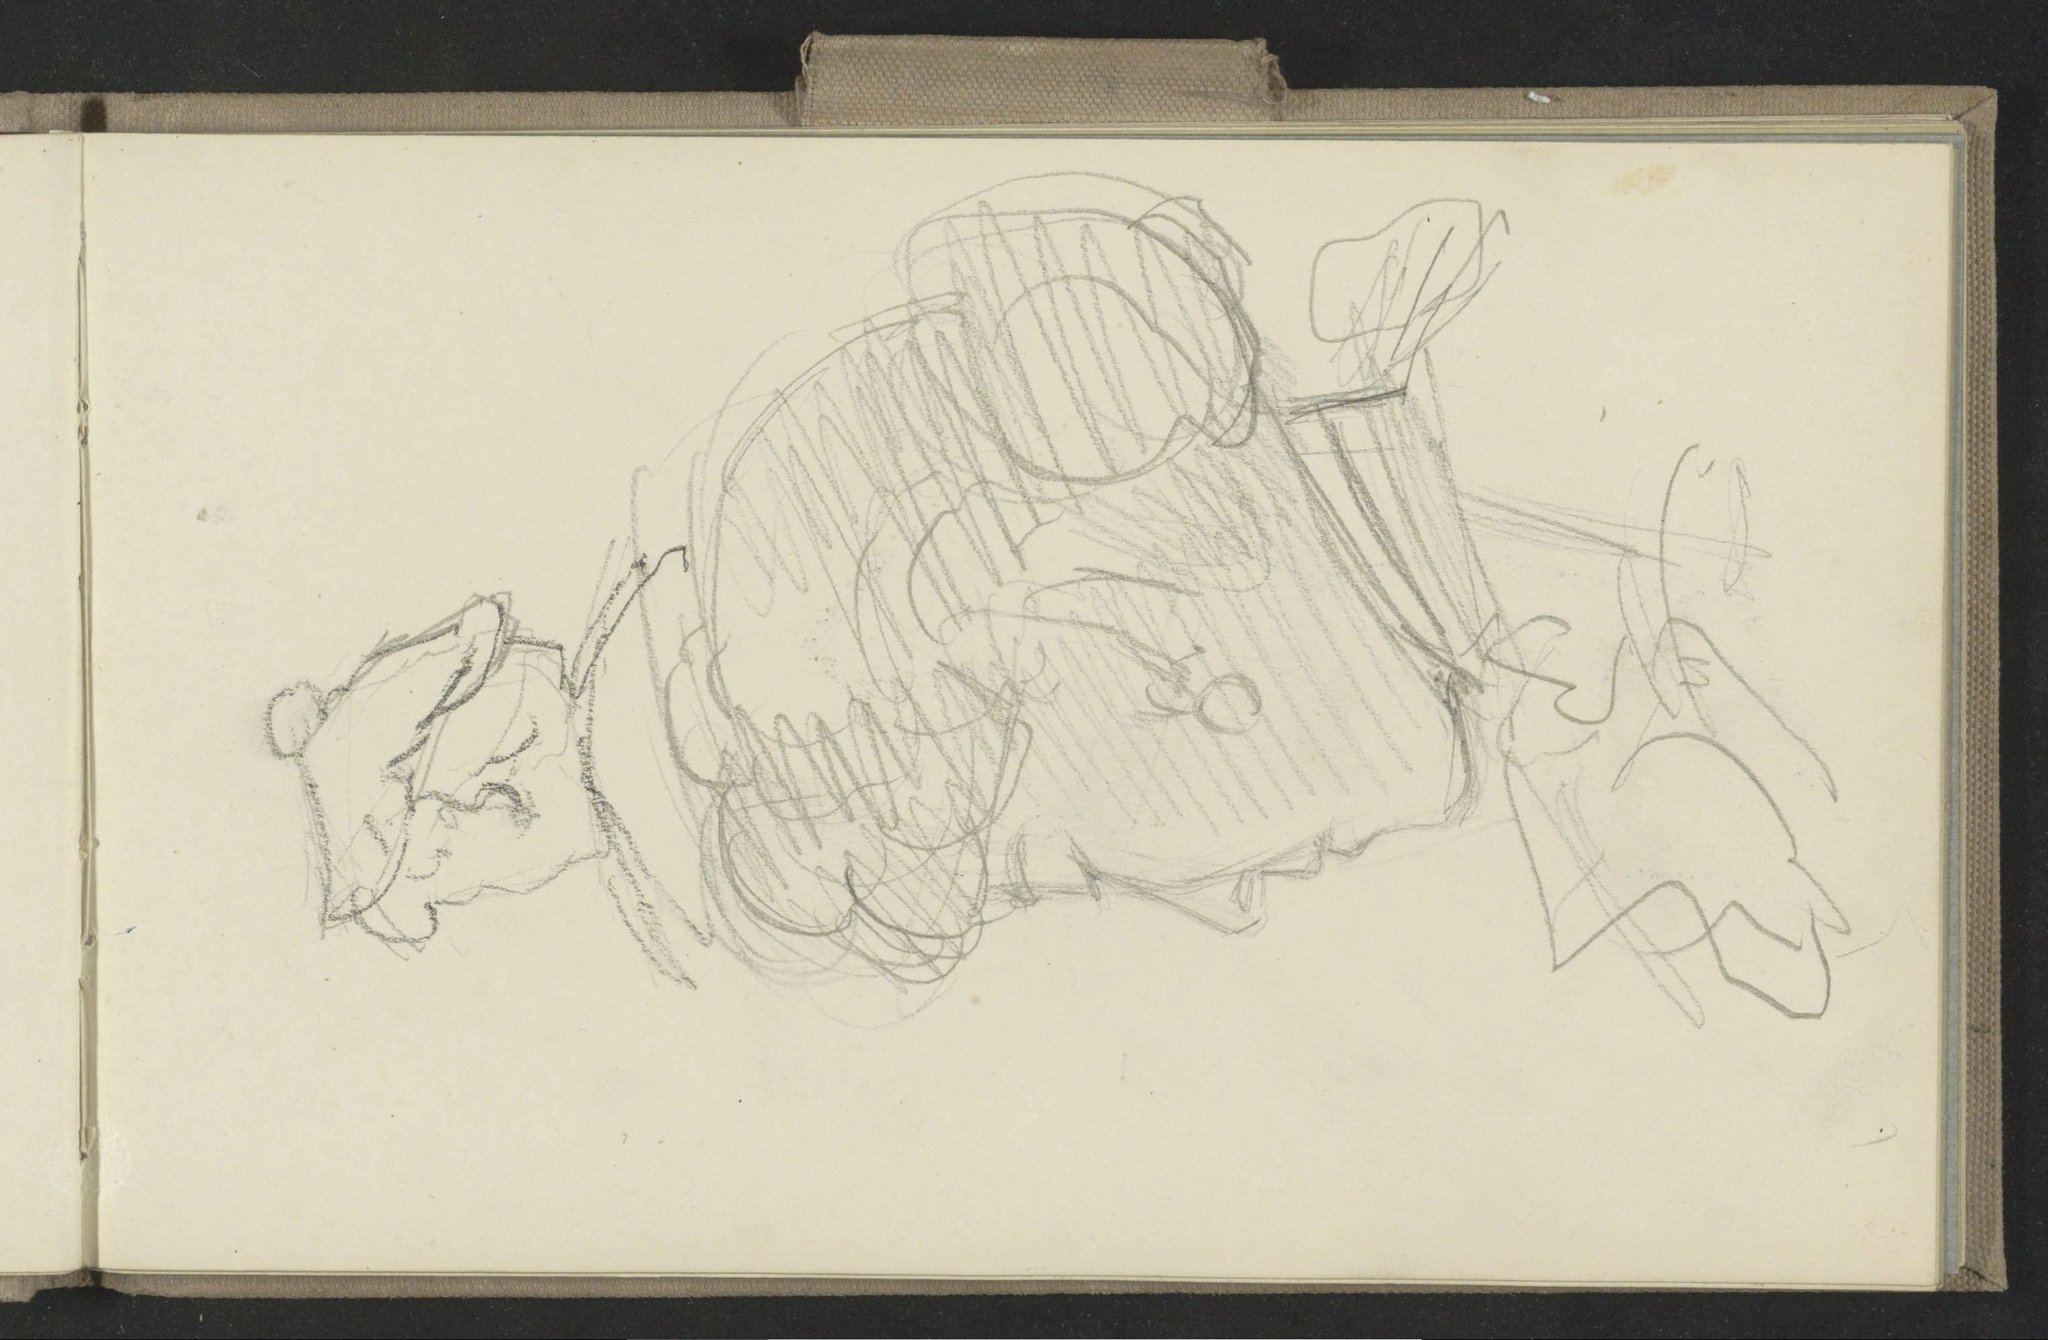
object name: sketchbook leaf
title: Twee vrouwenkoppen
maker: jozef israëls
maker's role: draughtsman, painter, print maker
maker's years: 1824-1911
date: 1834-1911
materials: paper, pencil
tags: head (human) (+ female (human being) (not to be used where -aa- is prescribed))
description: Blad 8 recto uit een schetsboek met 26 bladen.